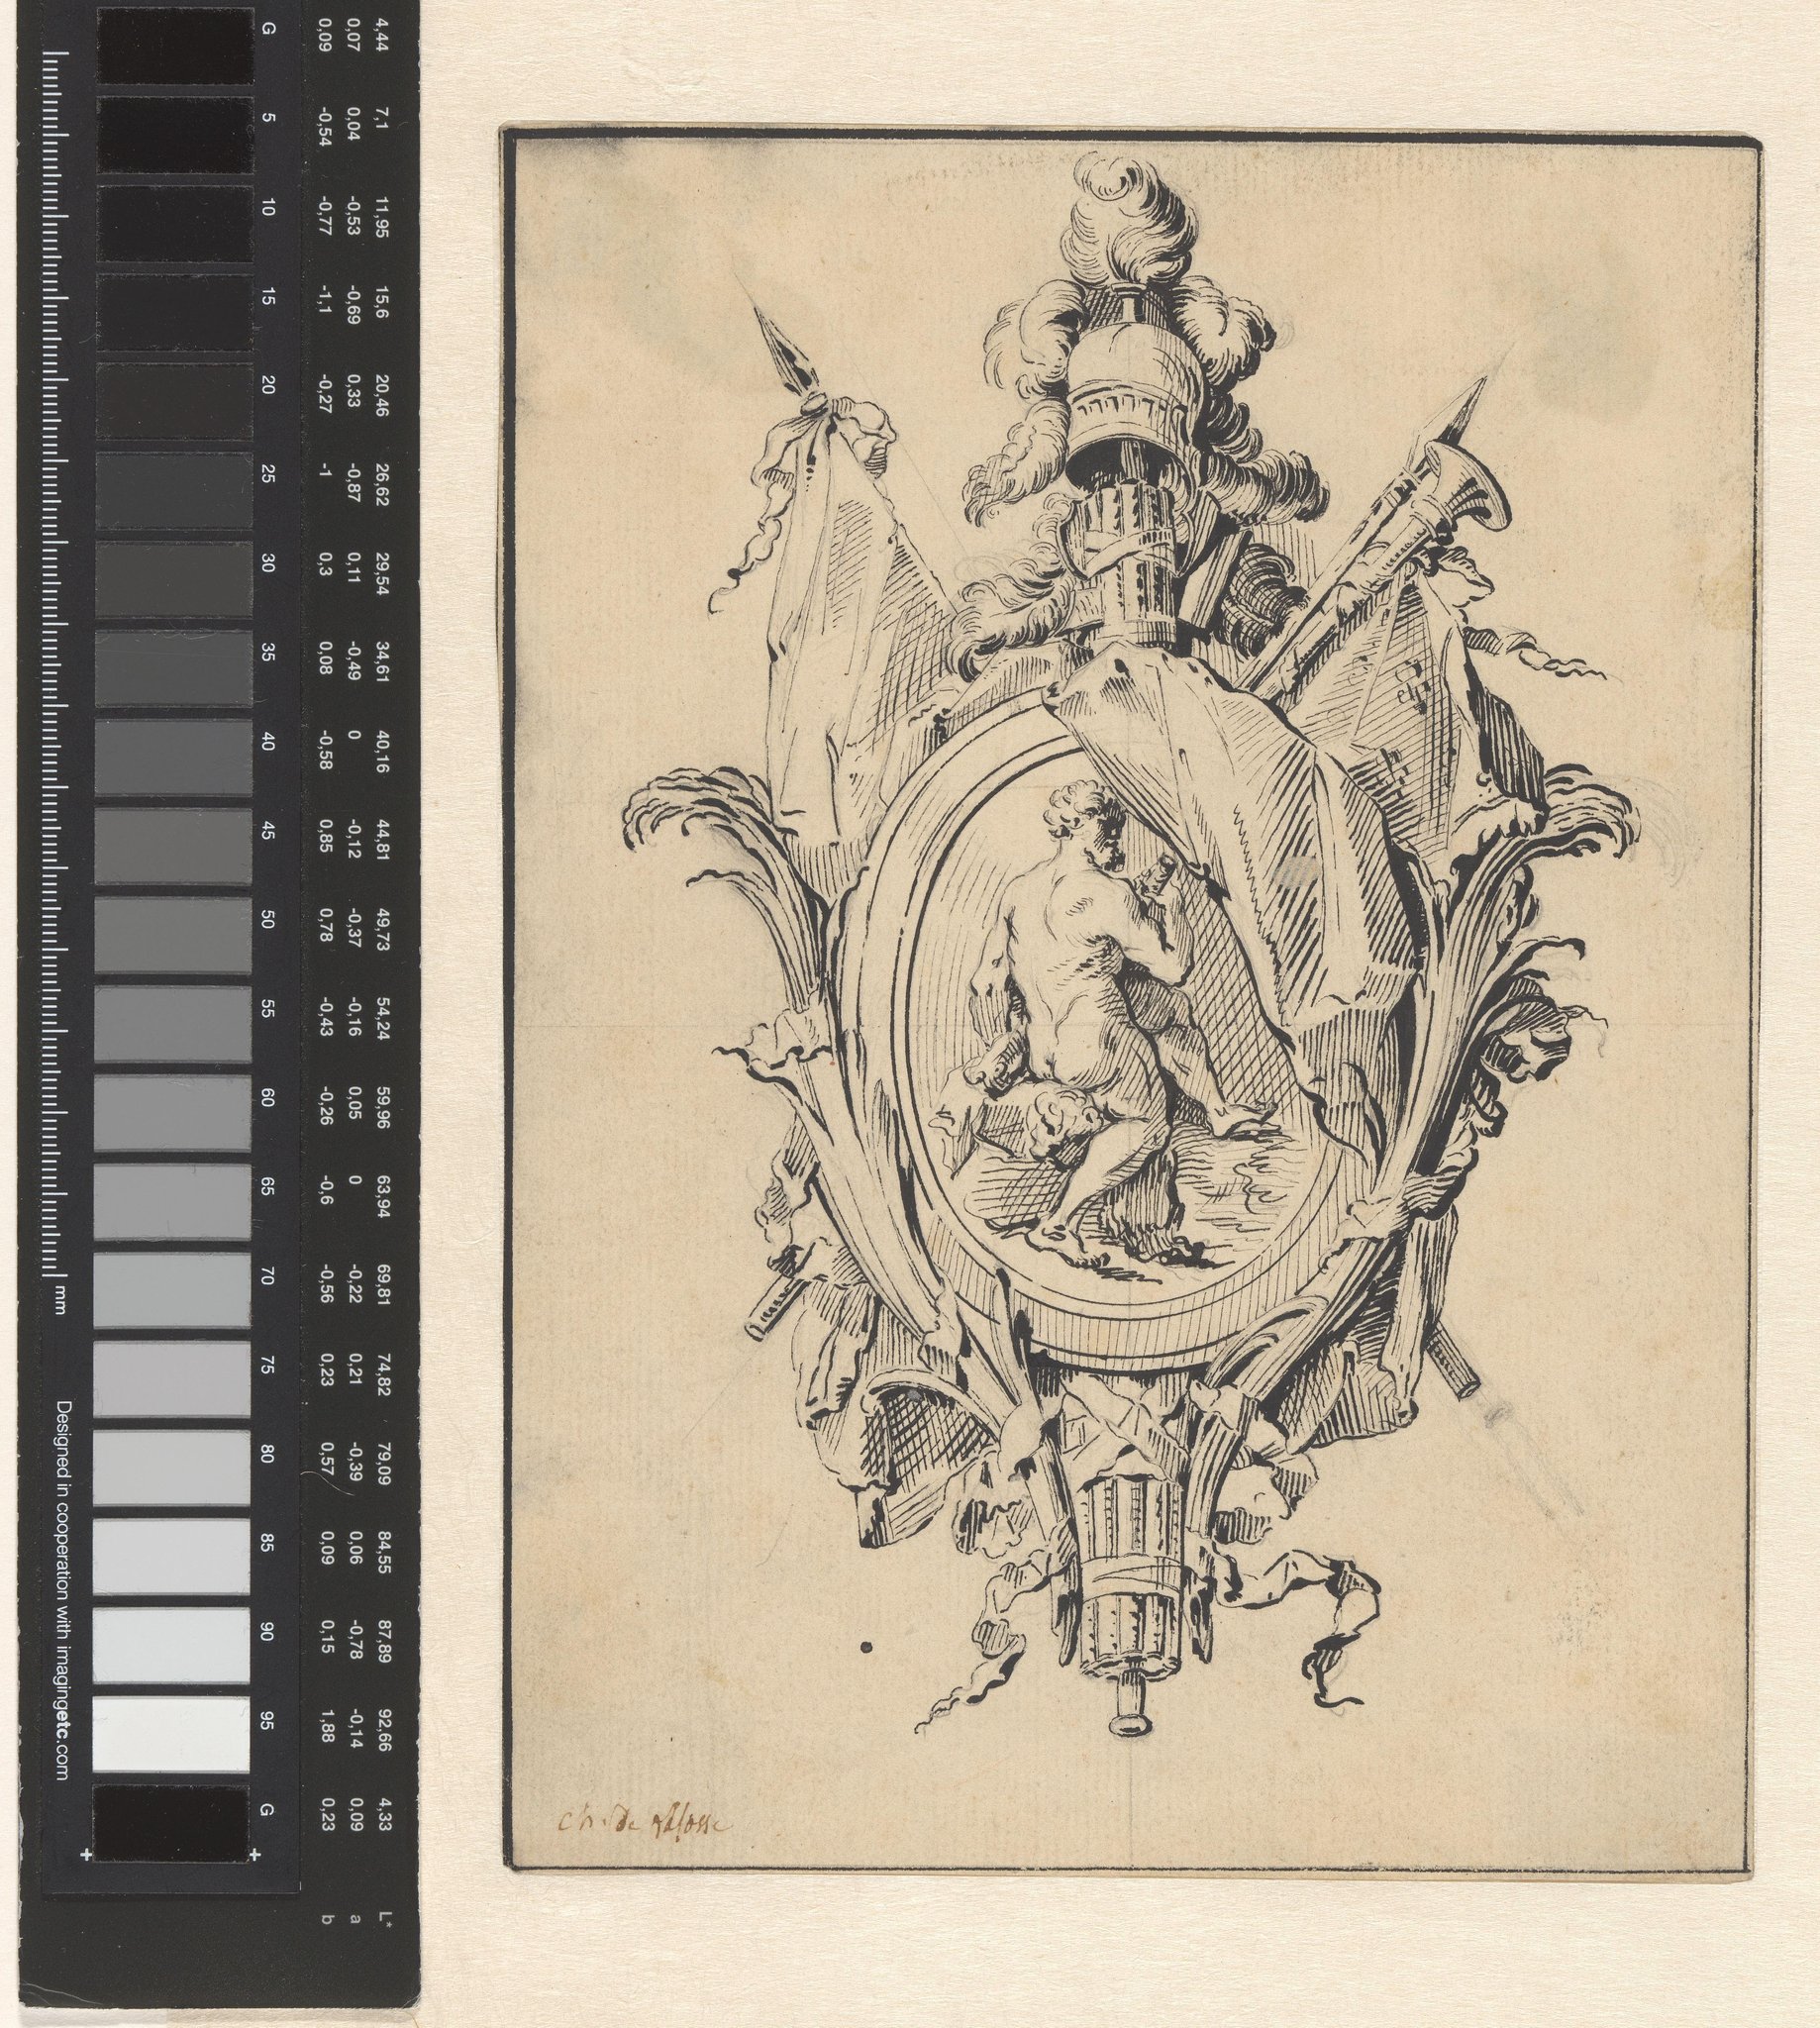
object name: design drawing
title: Cartouche met Hercules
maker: jean charles delafosse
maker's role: print maker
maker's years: 1734-1791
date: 1770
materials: paper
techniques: drawing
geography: paris